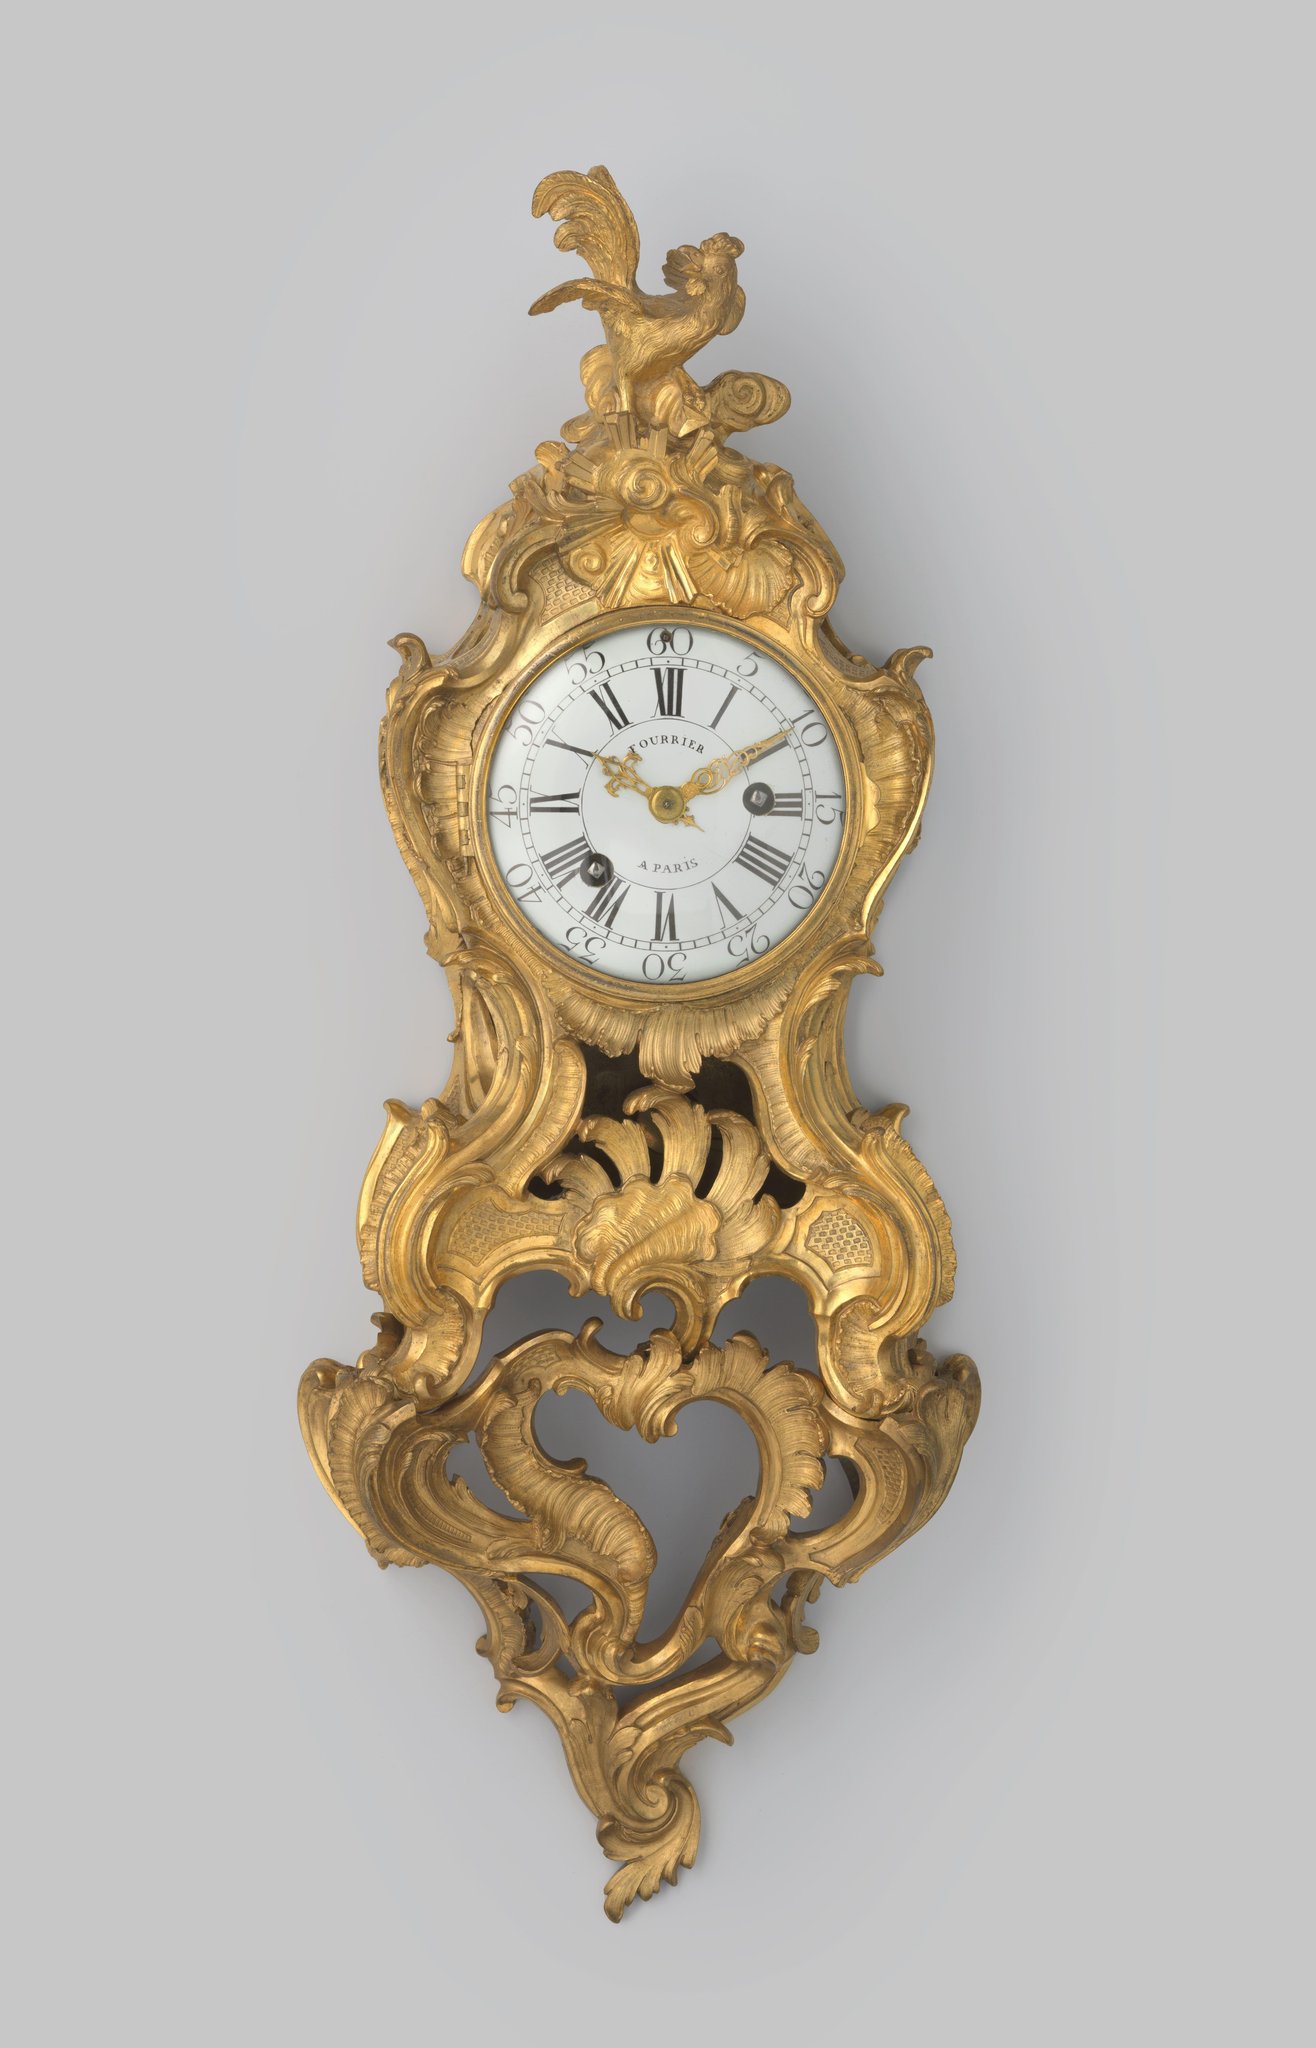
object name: sling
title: Consoleklok van verguld en geciseleerd brons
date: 1745-1749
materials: brass, bronze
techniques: gilding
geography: paris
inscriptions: inscription: ‘Richard (?) 785’, signature: ‘FOURRIER A PARIS’, signature: ‘Fourrier AParis’, mark, mark, signature: ‘fourrier a paris (?)’, signature: ‘.j.boullé l[e] jeune’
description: Slinger van de consoleklok van verguld en geciseleerd brons. De console in de vorm van een gelijkzijdige driehoek vertoont opengewerkte, asymmetrische rocaille-motieven. De klok is op dergelijke wijze versierd en rust op overhoeks geplaatste C-vormige poten, die aan de voorzijde S-vormige bladvoluten dragen, waarop de ronde wijzerplaat steunt. Ter bekroning dient een kraaiende haan en een door de wolken schijnende zon. De zijkanten hebben opengewerkte ruitvormige vullingen. Op console controlemerk van de gekroonde C.